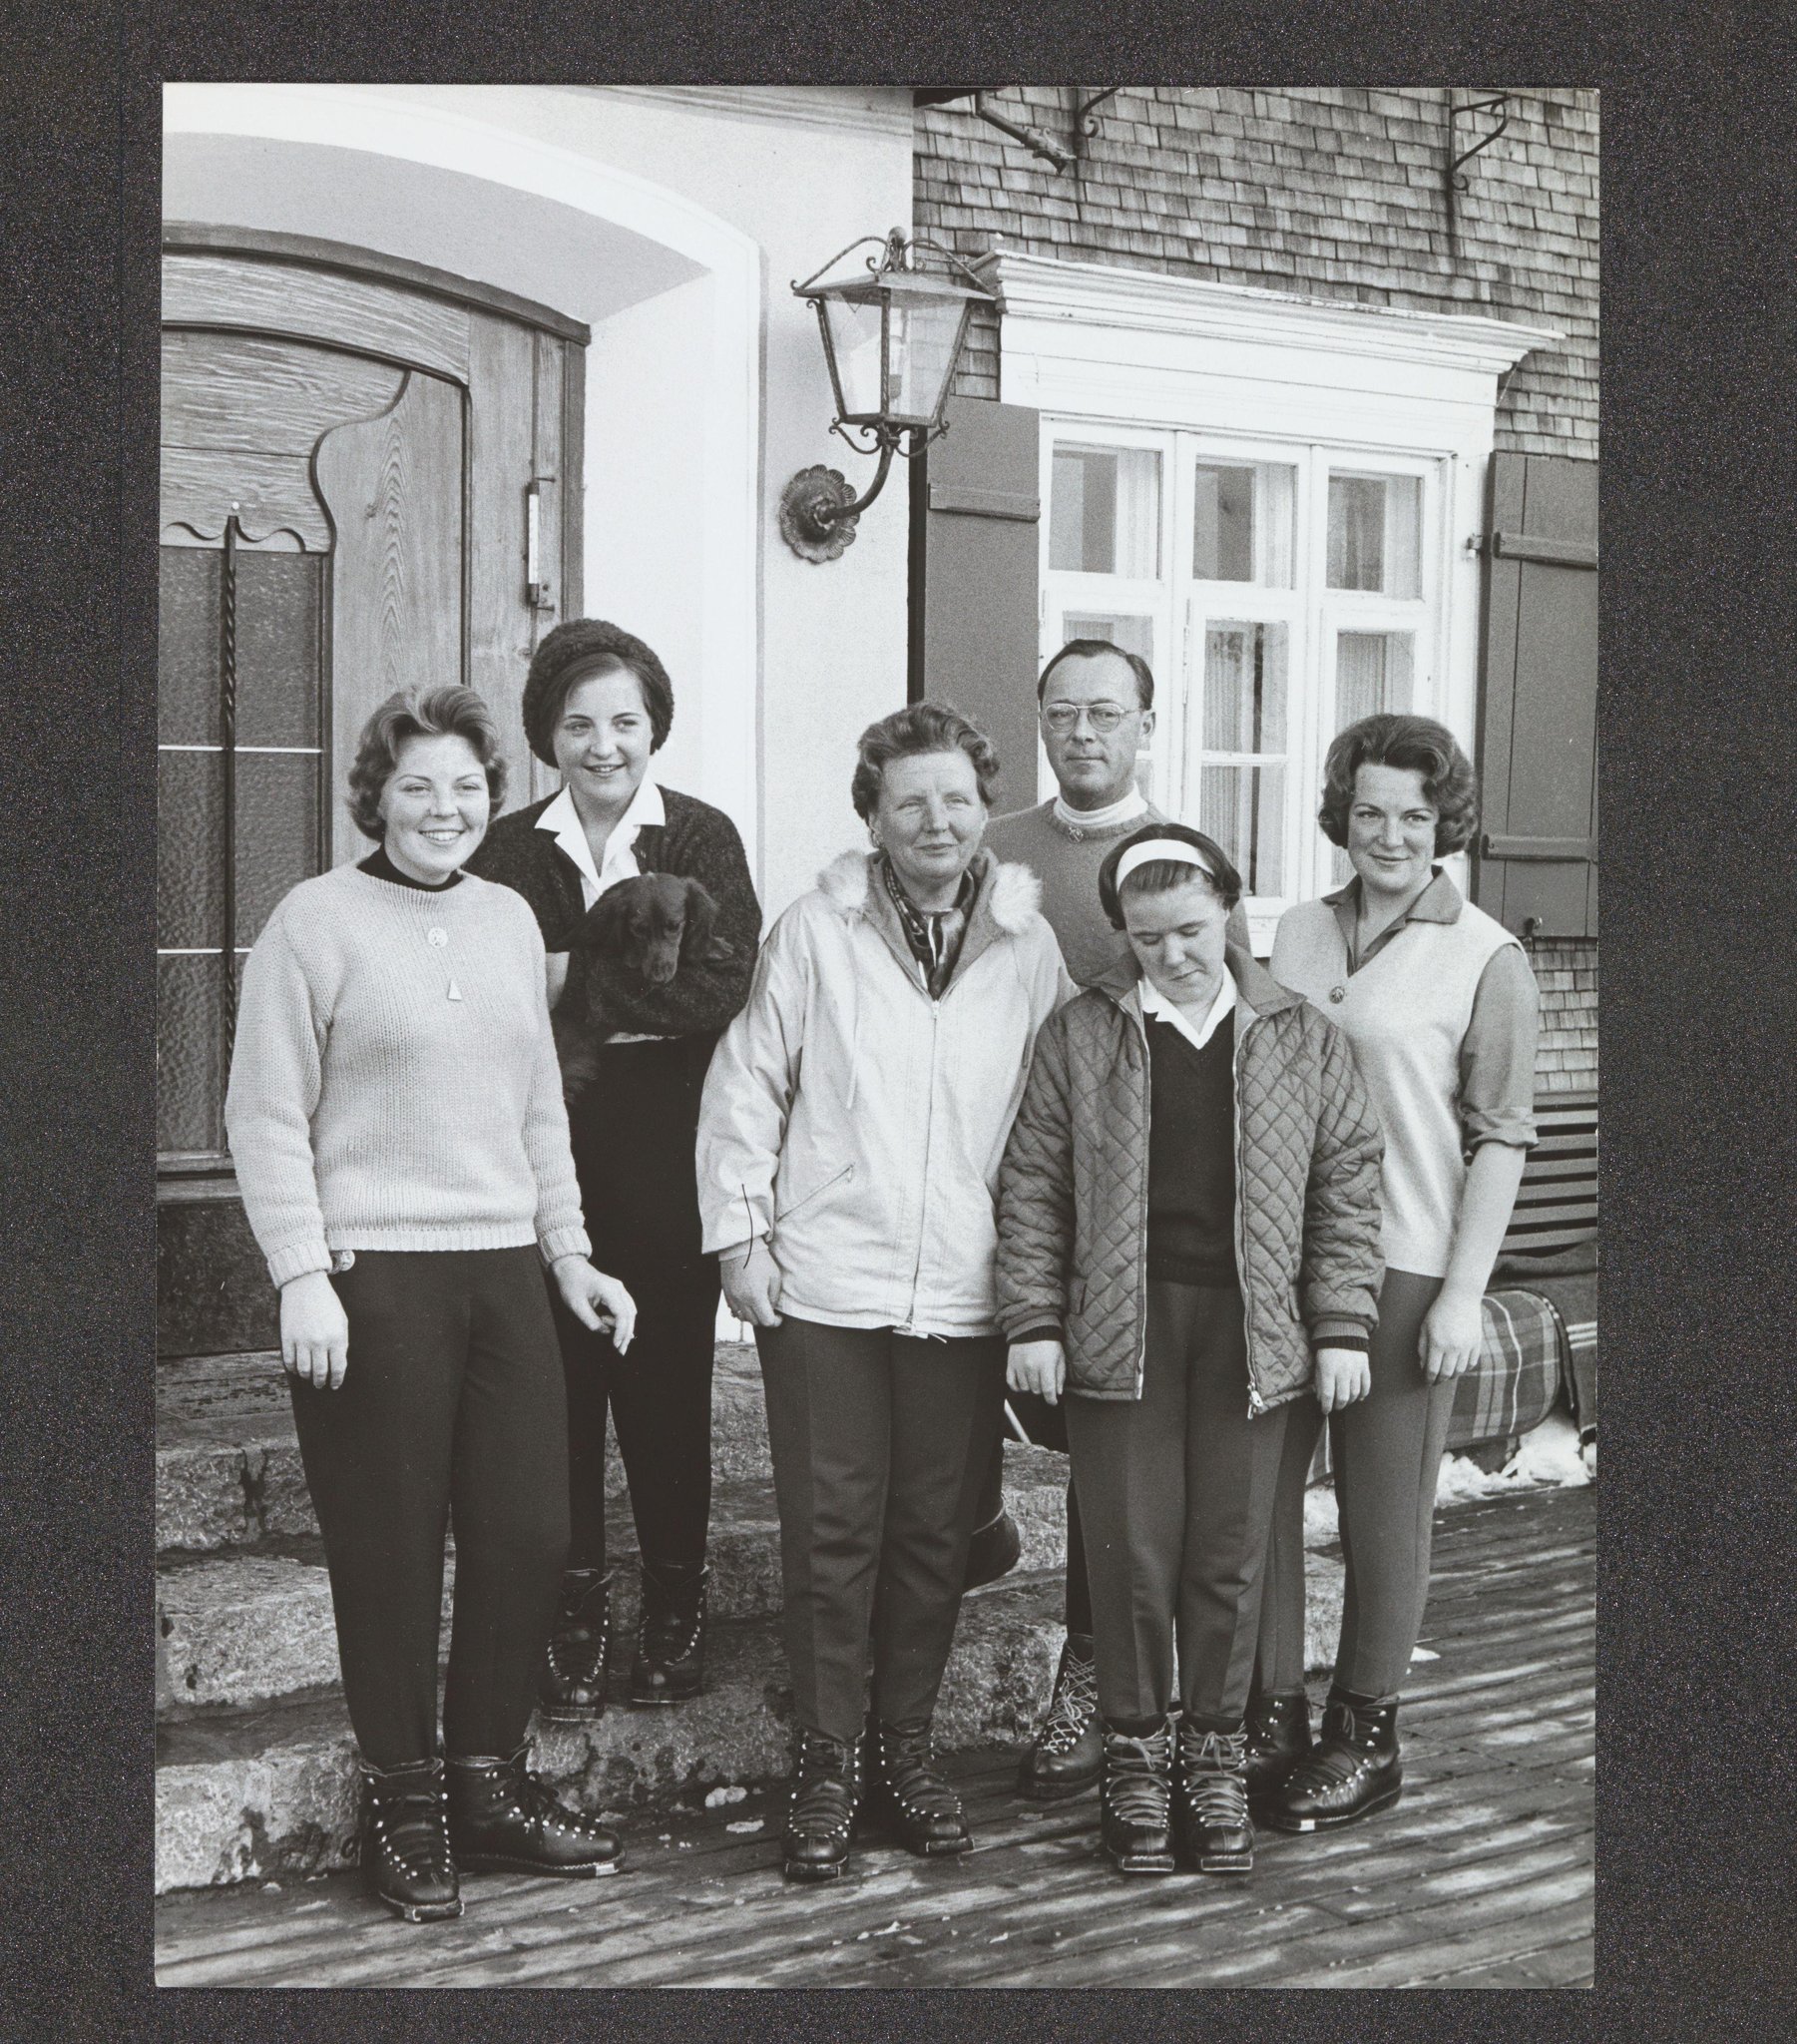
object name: photograph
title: Familieportret van de Nederlandse koninklijke familie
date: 1962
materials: paper, photographic support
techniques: gelatin silver print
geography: netherlands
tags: utrecht, bernhard (prins der nederlanden), beatrix (koningin der nederlanden), the hague, juliana of the netherlands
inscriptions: annotation: ‘Het koninklijke gezin poseerde voor hun hotel in Lech aan de vooravond van het 25-jarig huwelijksfeest, dat intiem in Lech wordt gevierd. Eind april en begin mai zal het grote feest in ons land worden gevierd.’